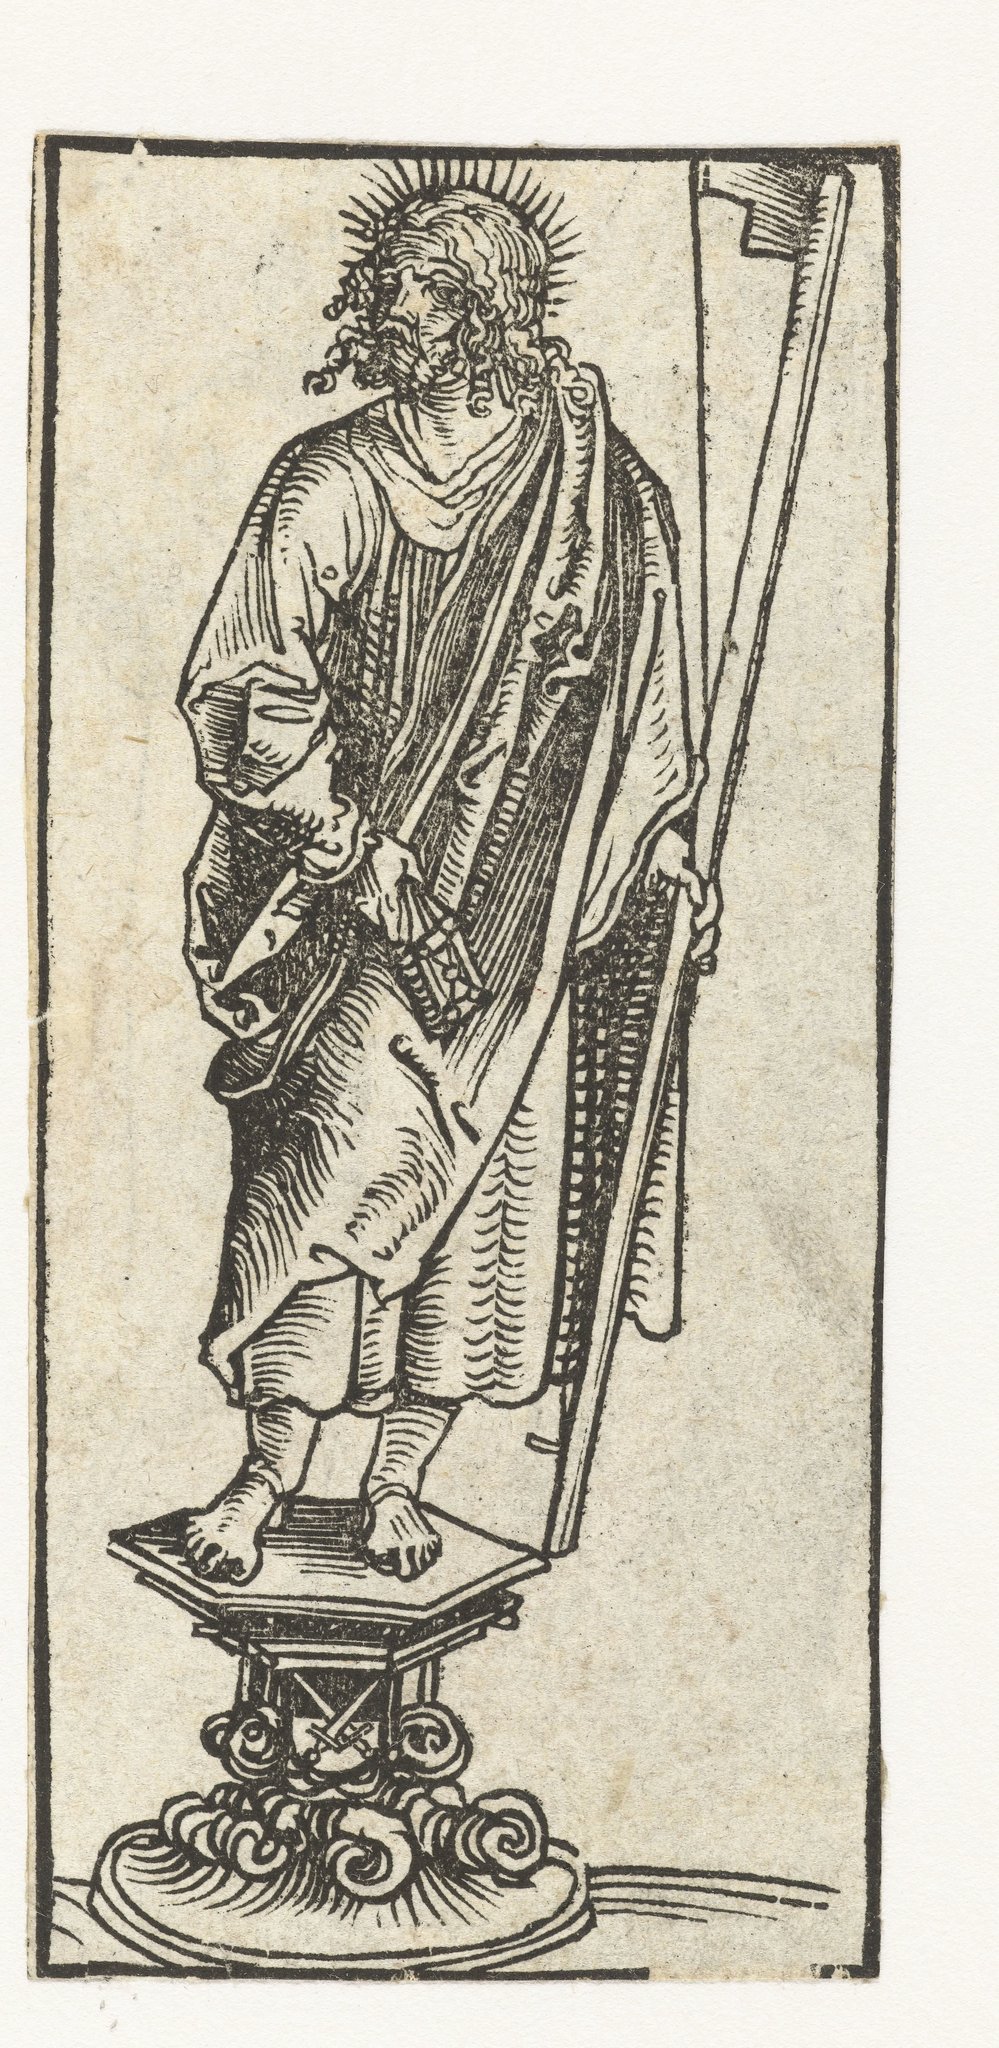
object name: print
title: Beeld met Jakobus de Mindere met hoedenmakersboog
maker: lucas cranach (i)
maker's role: draughtsman, print maker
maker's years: 1472-1553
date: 1509-1549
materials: paper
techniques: woodcut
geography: wittenberg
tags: the apostle james the less, first bishop of jerusalem; possible attributes: book, fuller's club, scroll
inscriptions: collector's mark: Lugt 240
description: Beeld met Jakobus de Mindere (Jacobus Minor) staand met een hoedenmakersboog in zijn hand, op een voet versierd met krulornamenten en schild met het keurvorstelijk wapen van Saksen. Op het verso van deze boekillustratie staat een fragment van een beeld van een heilige, mogelijk in liturgische kleding, met een staf in zijn hand.